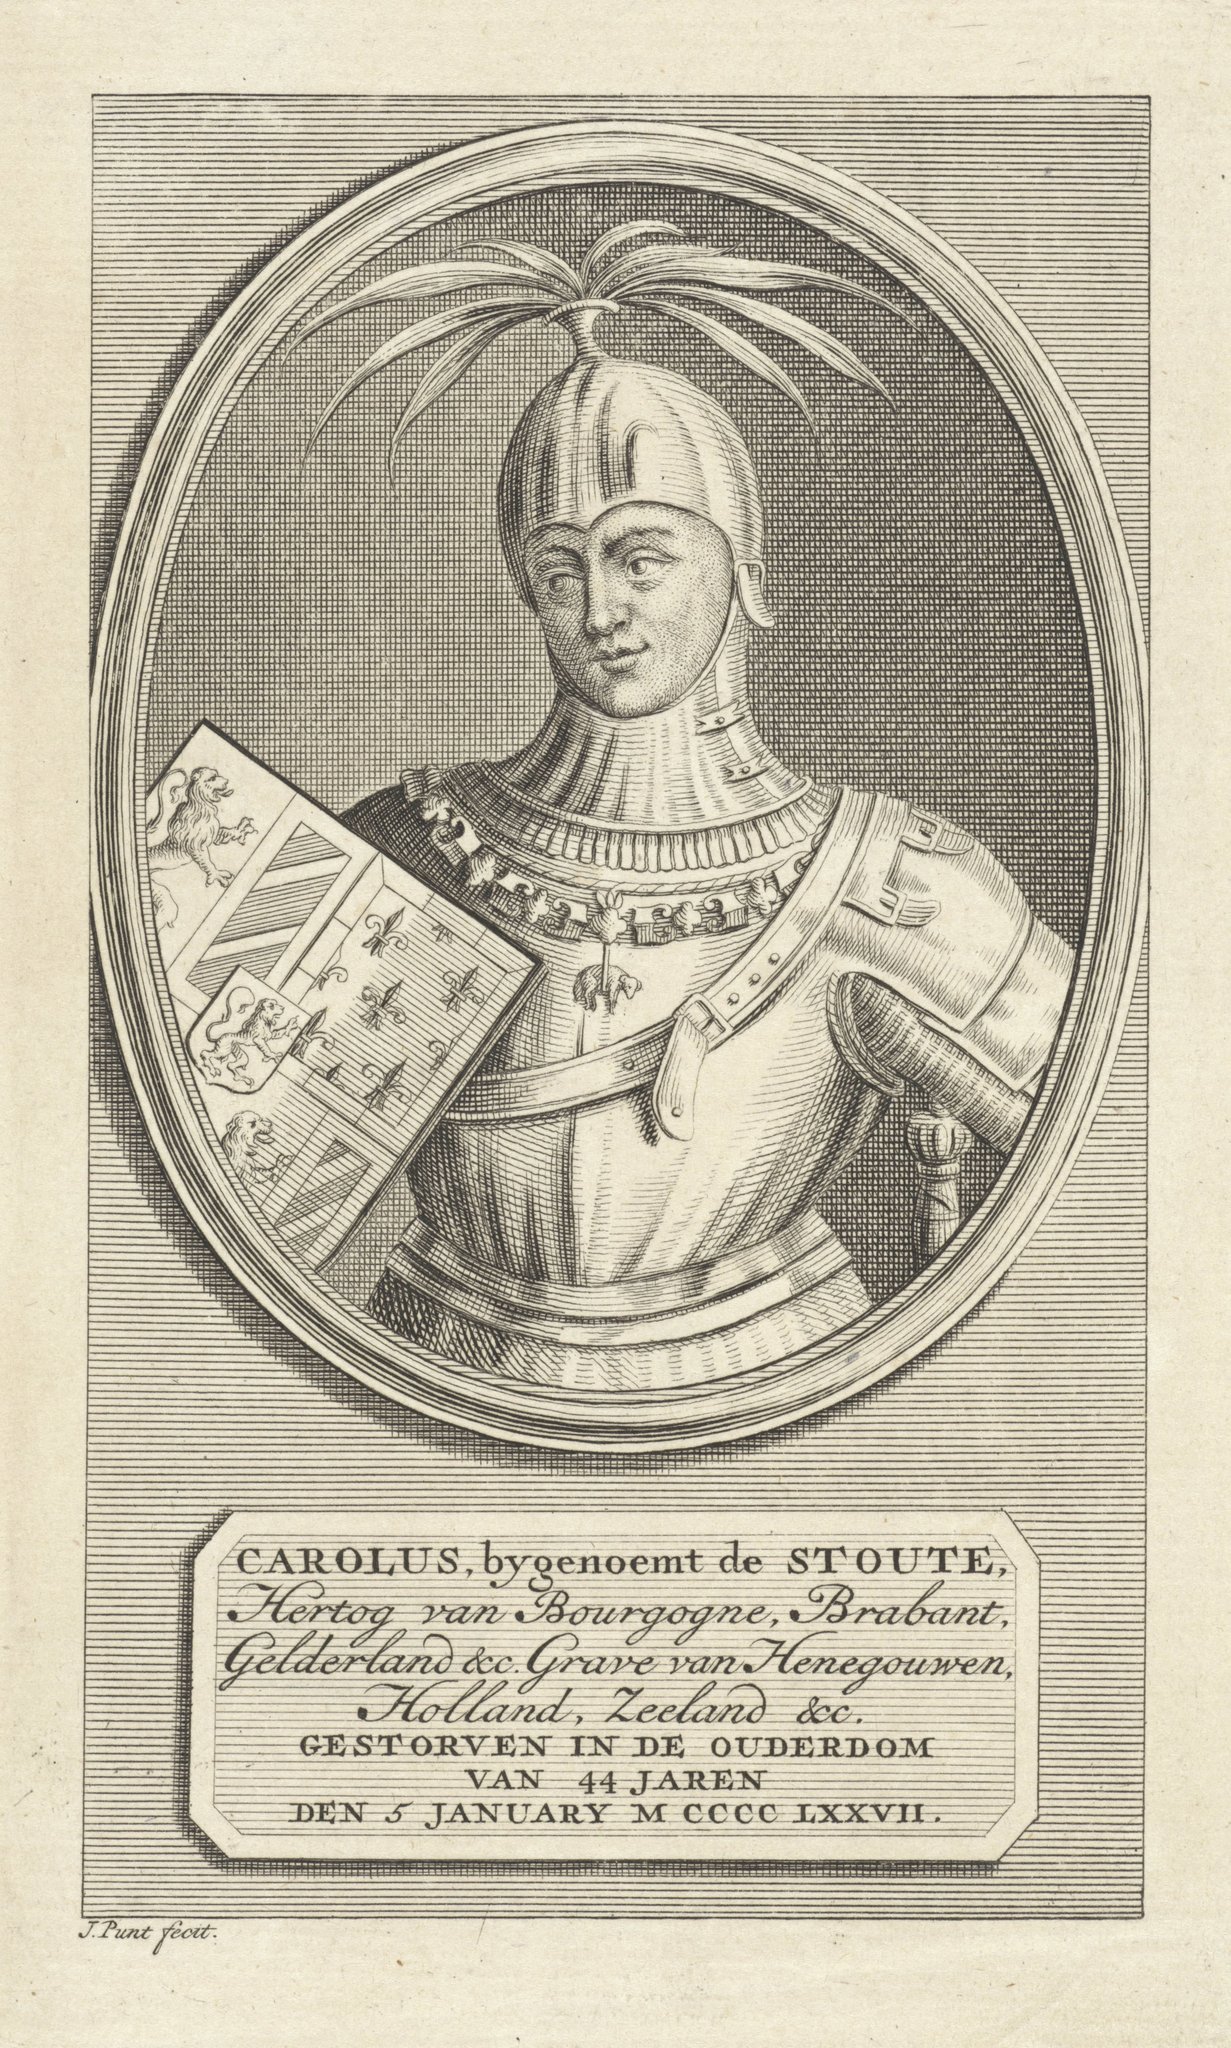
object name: book illustration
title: Portret van Karel de Stoute, hertog van Bourgondië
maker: jan punt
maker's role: draughtsman, print maker, publisher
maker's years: 1711-1779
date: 1786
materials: paper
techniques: engraving, etching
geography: northern netherlands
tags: earl, charles the bold (duke of burgundy), armour, knighthood order of the golden fleece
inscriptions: collector's mark: Lugt 2228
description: Prent gebruikt als illustratie in: Meteren, Emanuel van. Oorlogen en geschiedenissen der Nederlanderen en derzelver nabuuren, deel I, p. 15. Amsterdam: Steven Jacobus Baalde, 1786.